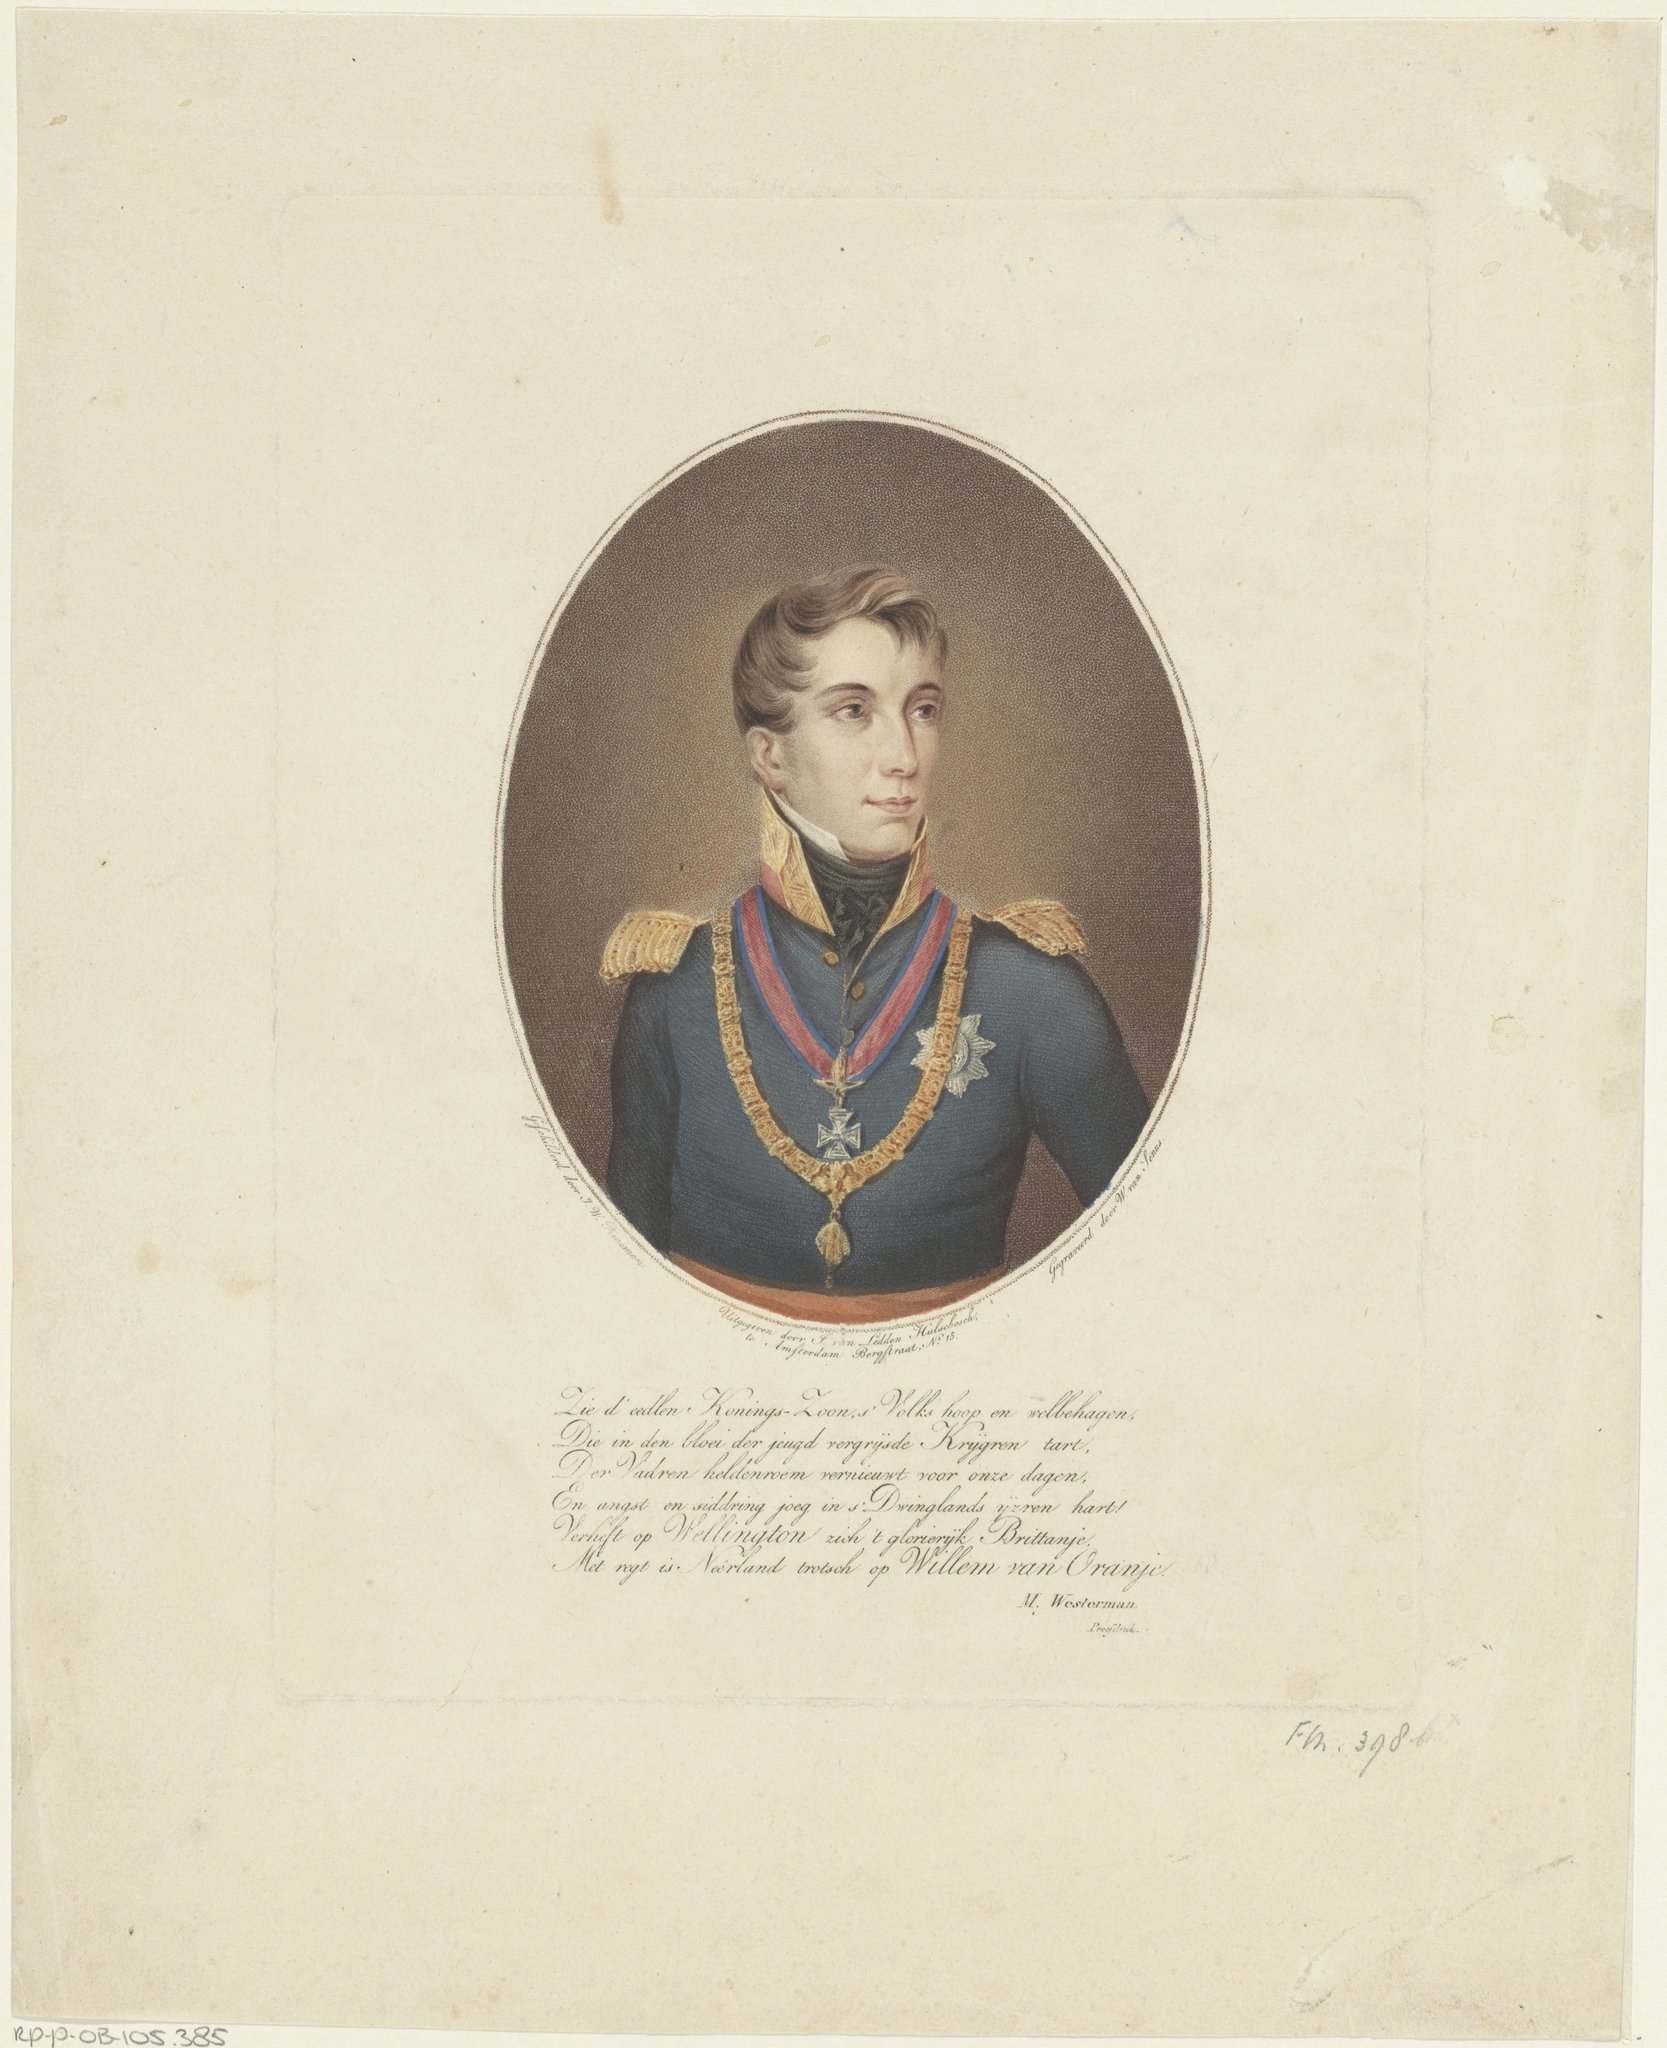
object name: print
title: Portret van Willem II, koning der Nederlanden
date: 1814-1819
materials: paper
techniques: engraving, etching, hand coloring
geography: amsterdam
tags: the hague, william ii of the netherlands, knighthood order of the golden fleece - insignia of a knighthood order, e.g.: badge, chain (with name of order)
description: De hier vermelde titel verwijst naar de hoogst verkregen titel van de geportretteerde, niet per se naar de titel die de geportretteerde op deze voorstelling draagt.